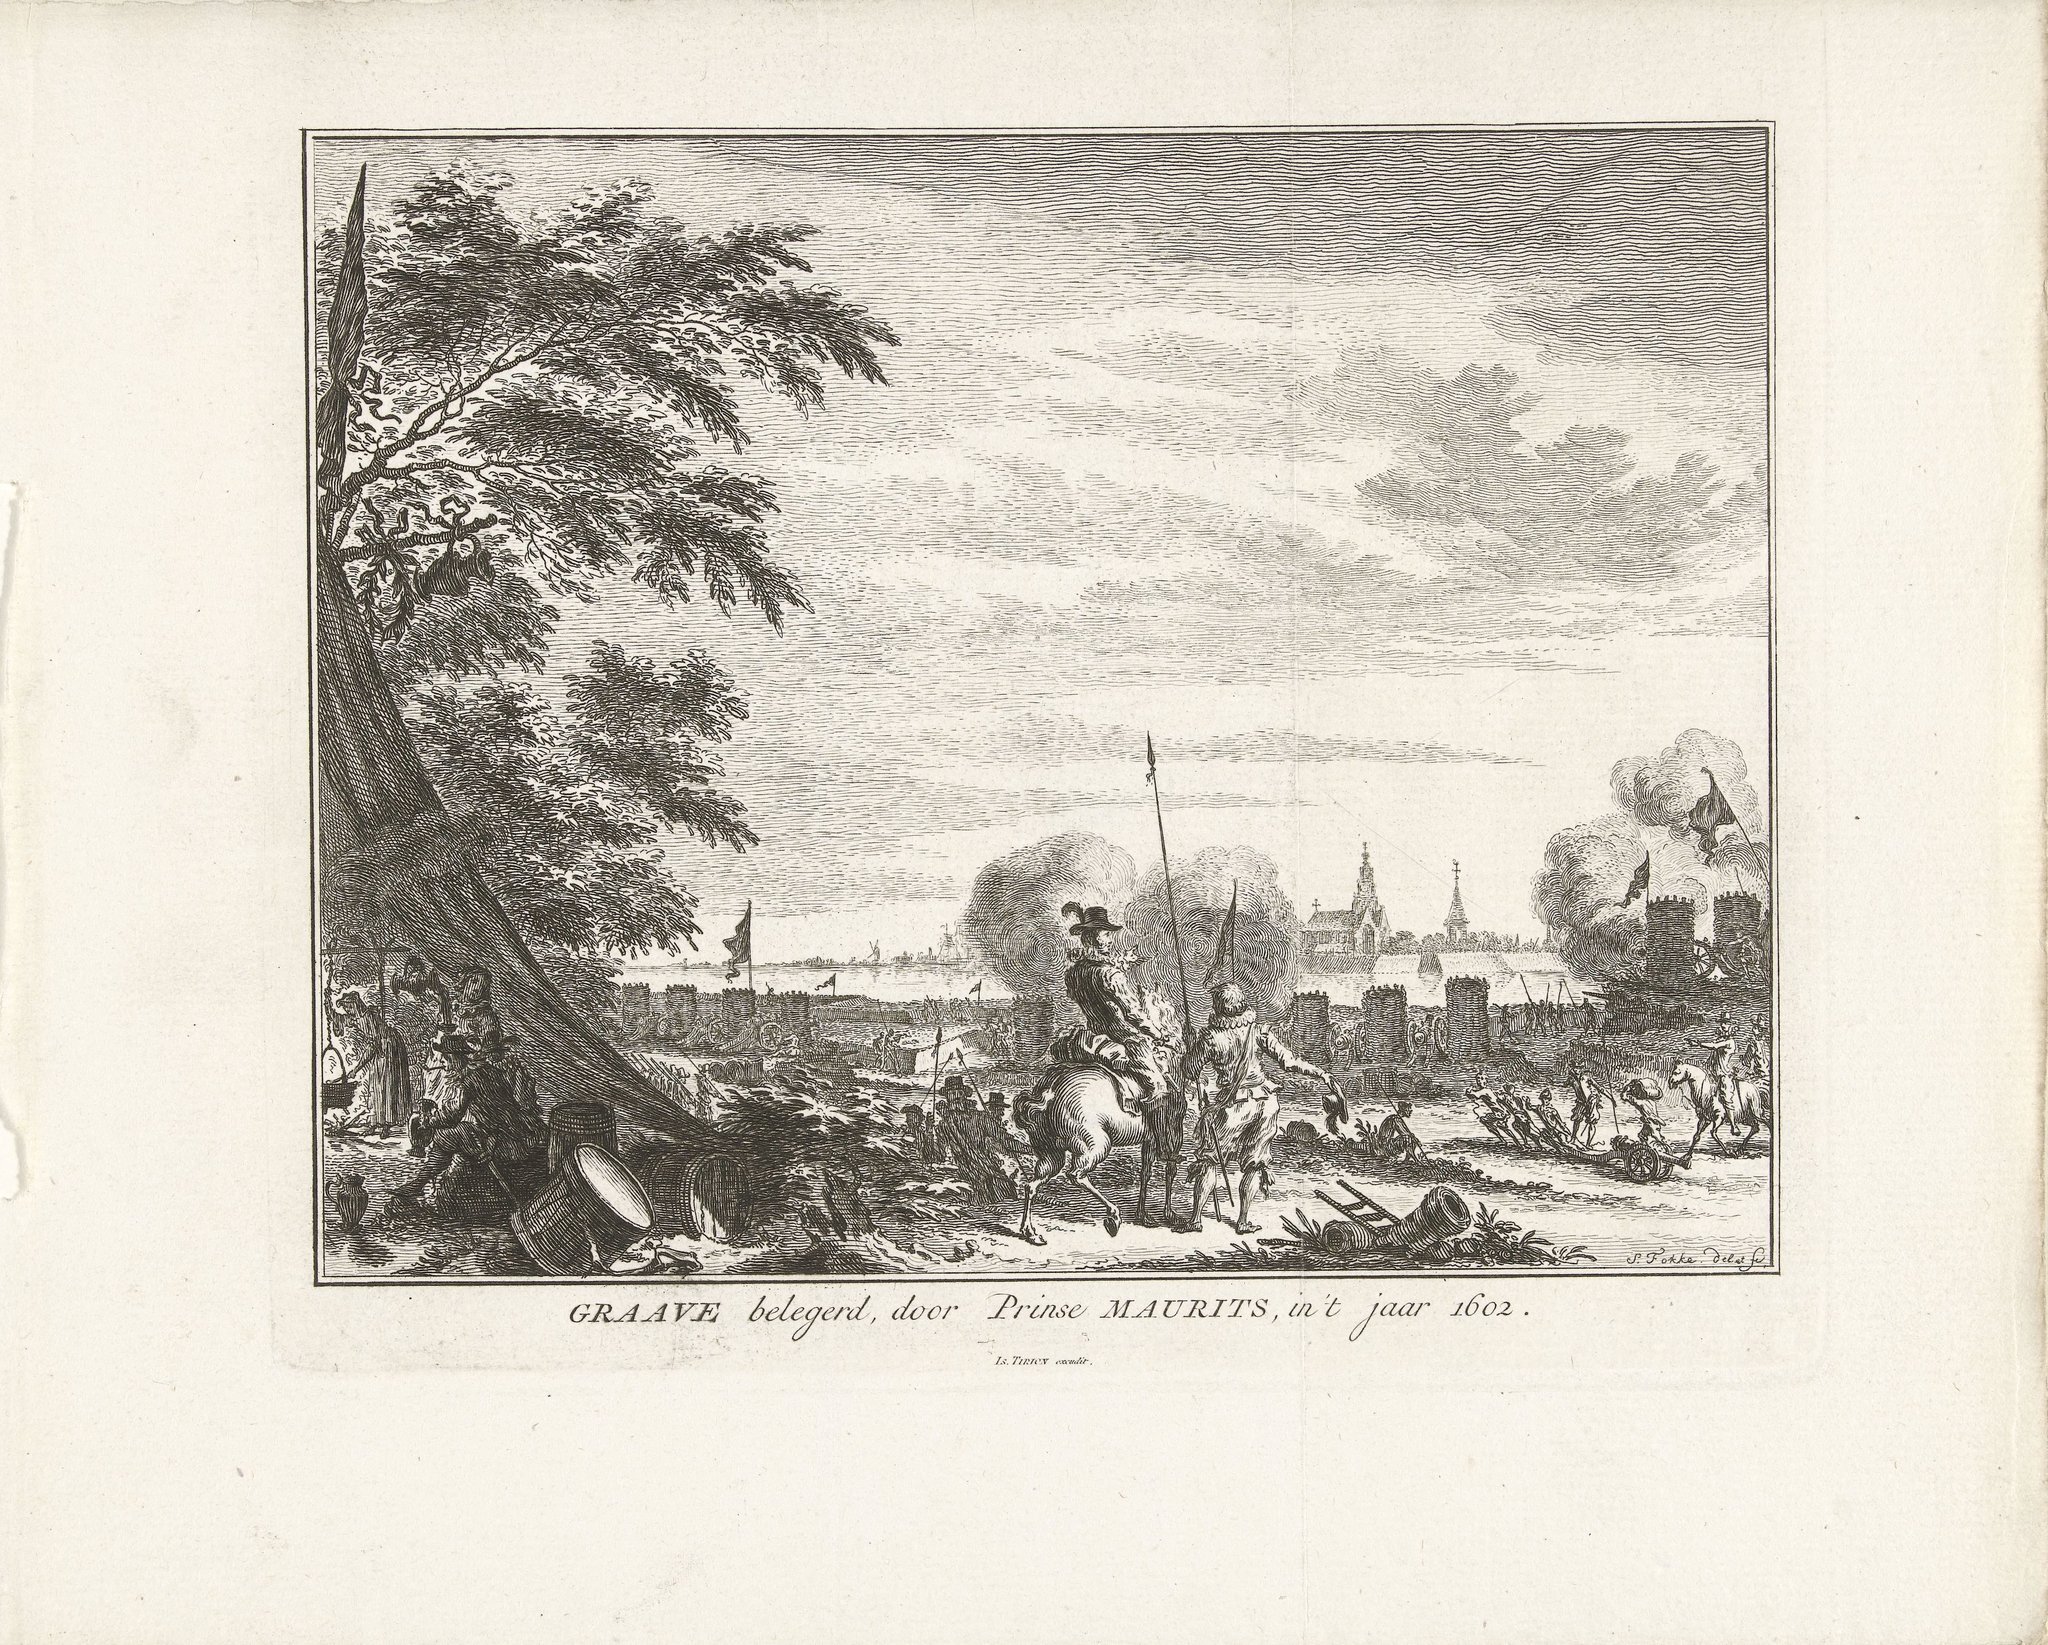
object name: print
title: Graave belegerd, door Prinse Maurits, in 't jaar 1602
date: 1729-1766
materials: paper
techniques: etching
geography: amsterdam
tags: the hague, maurice (prince of orange), siege, position war, grave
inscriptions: collector's mark: Lugt 2228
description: De stad Grave, belegerd en veroverd door het Staatse leger onder prins Maurits. De prins te paard in het legerkamp, in de verte het profiel van de stad.